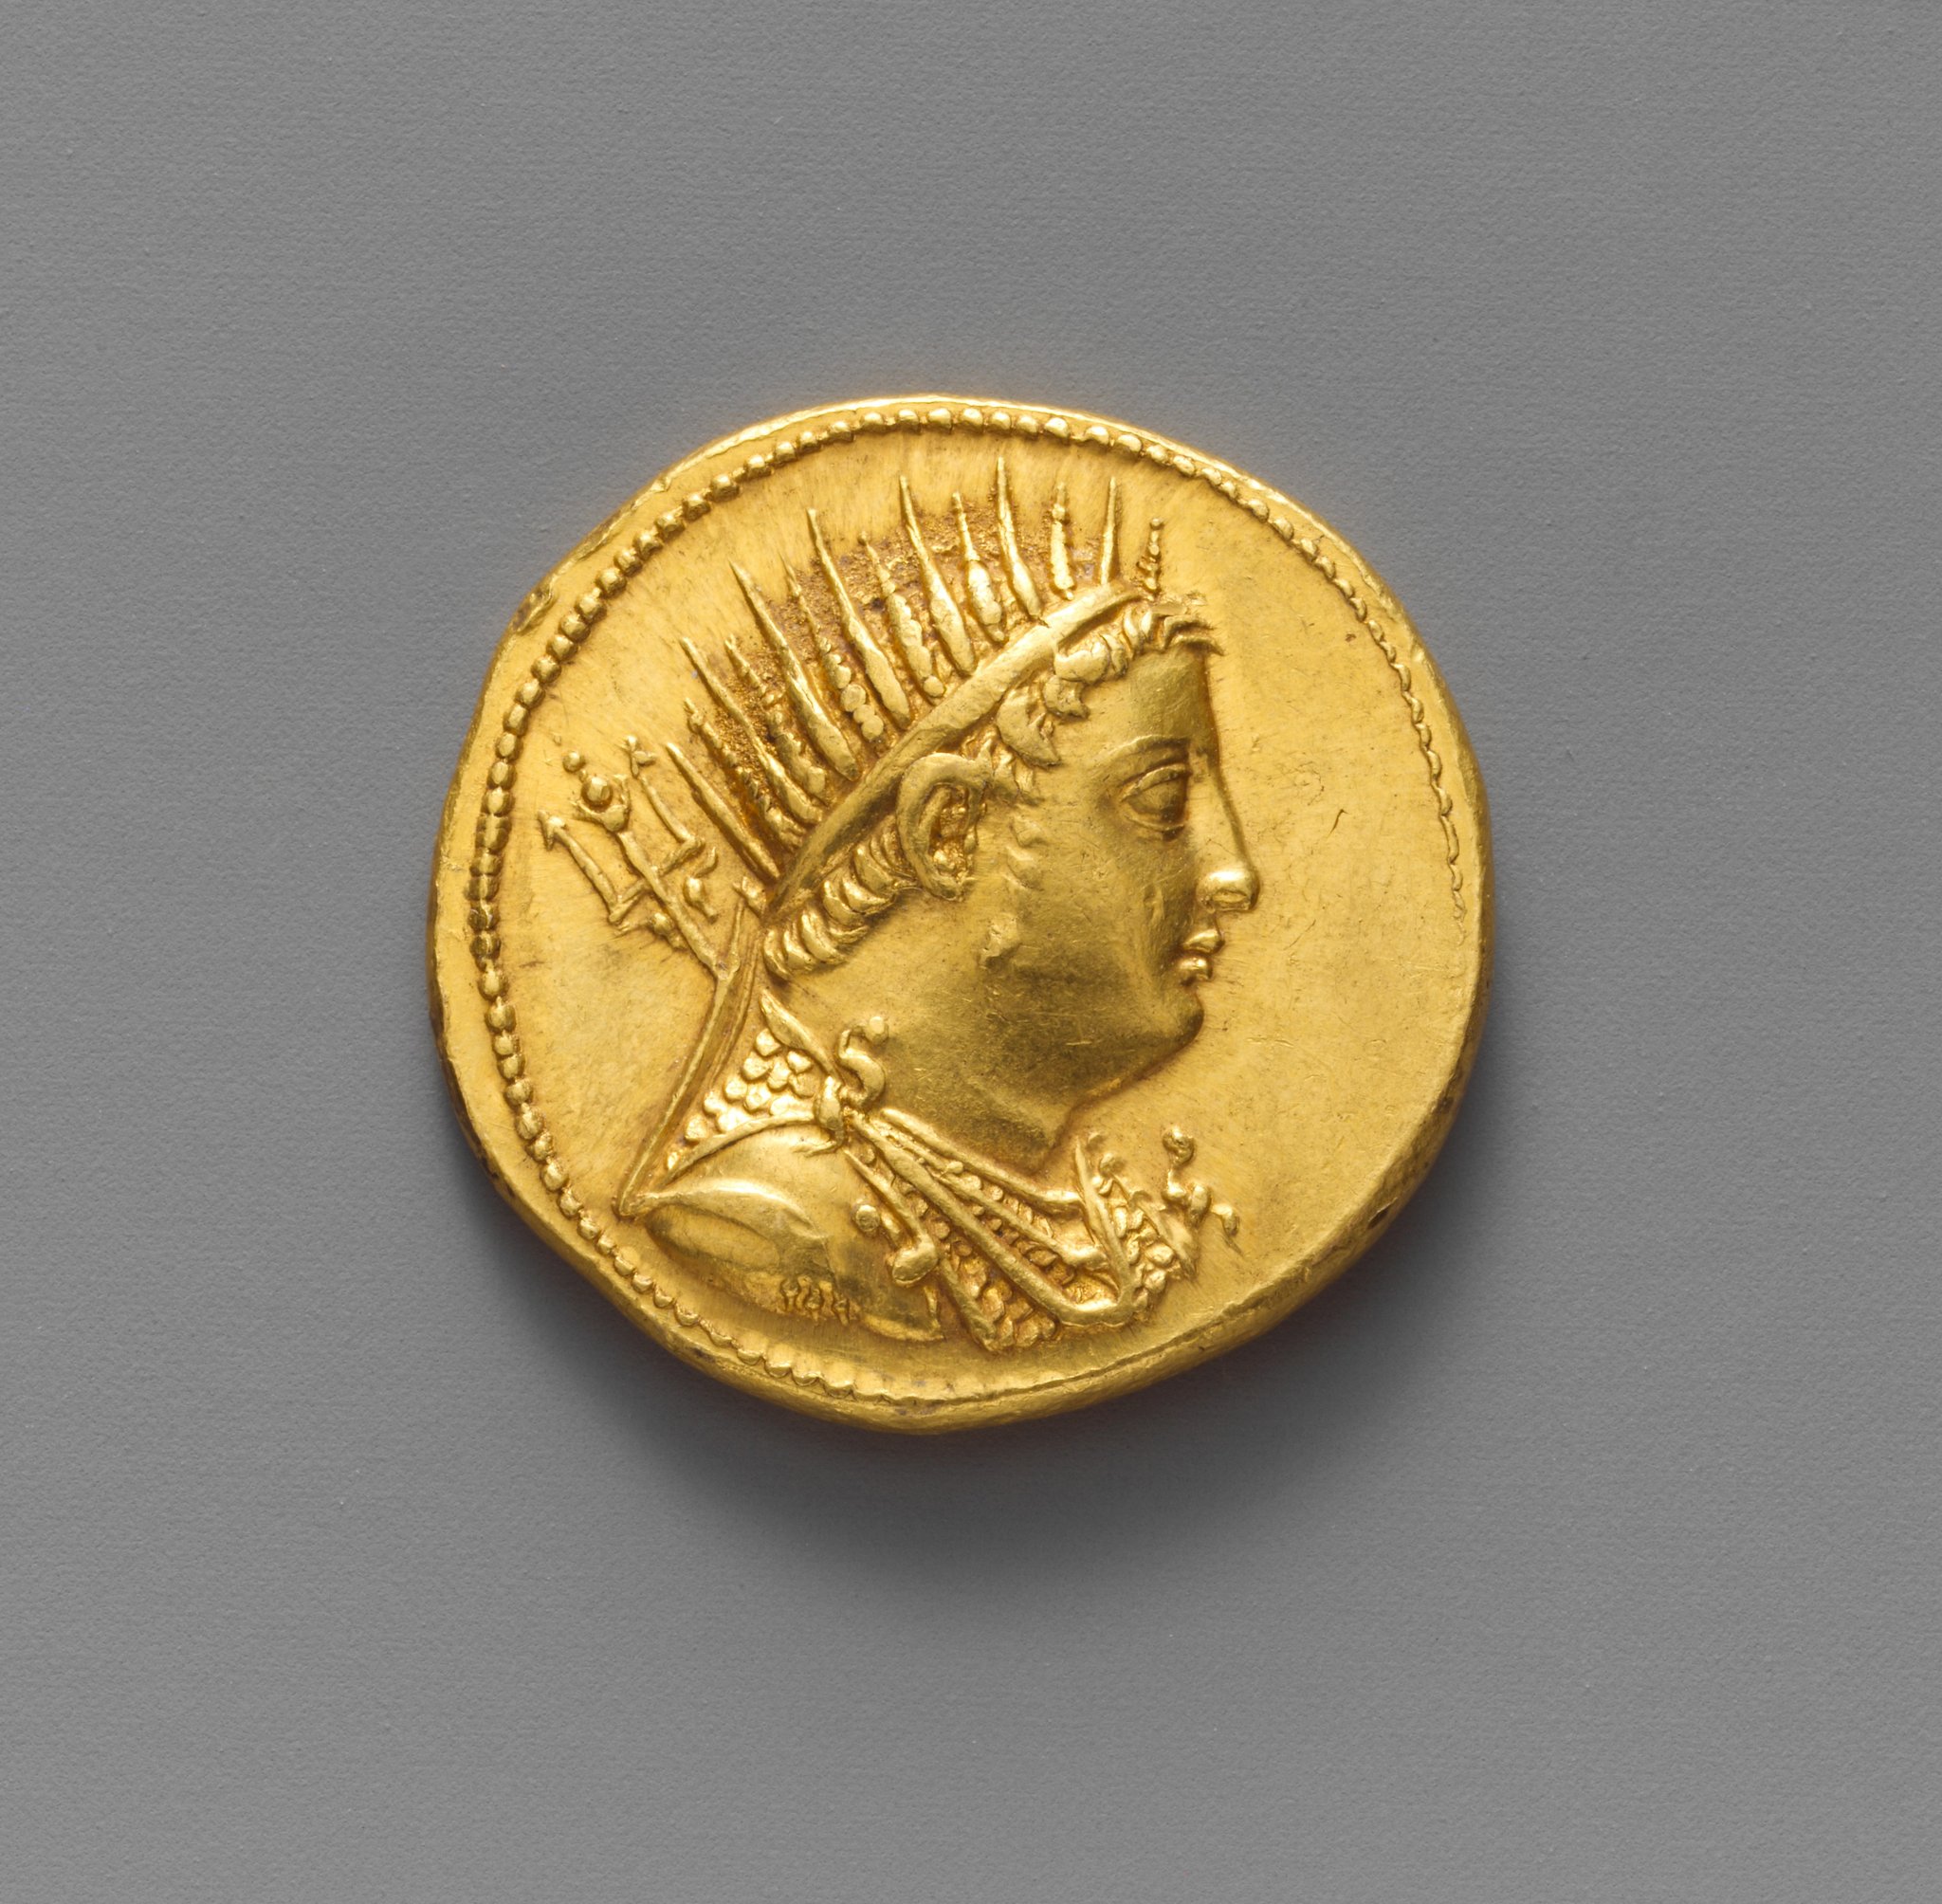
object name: oktadrachm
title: Gold oktadrachm of Ptolemy IV Philopator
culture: greek, ptolemaic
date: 221-204 BCE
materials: gold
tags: men,profiles,coins